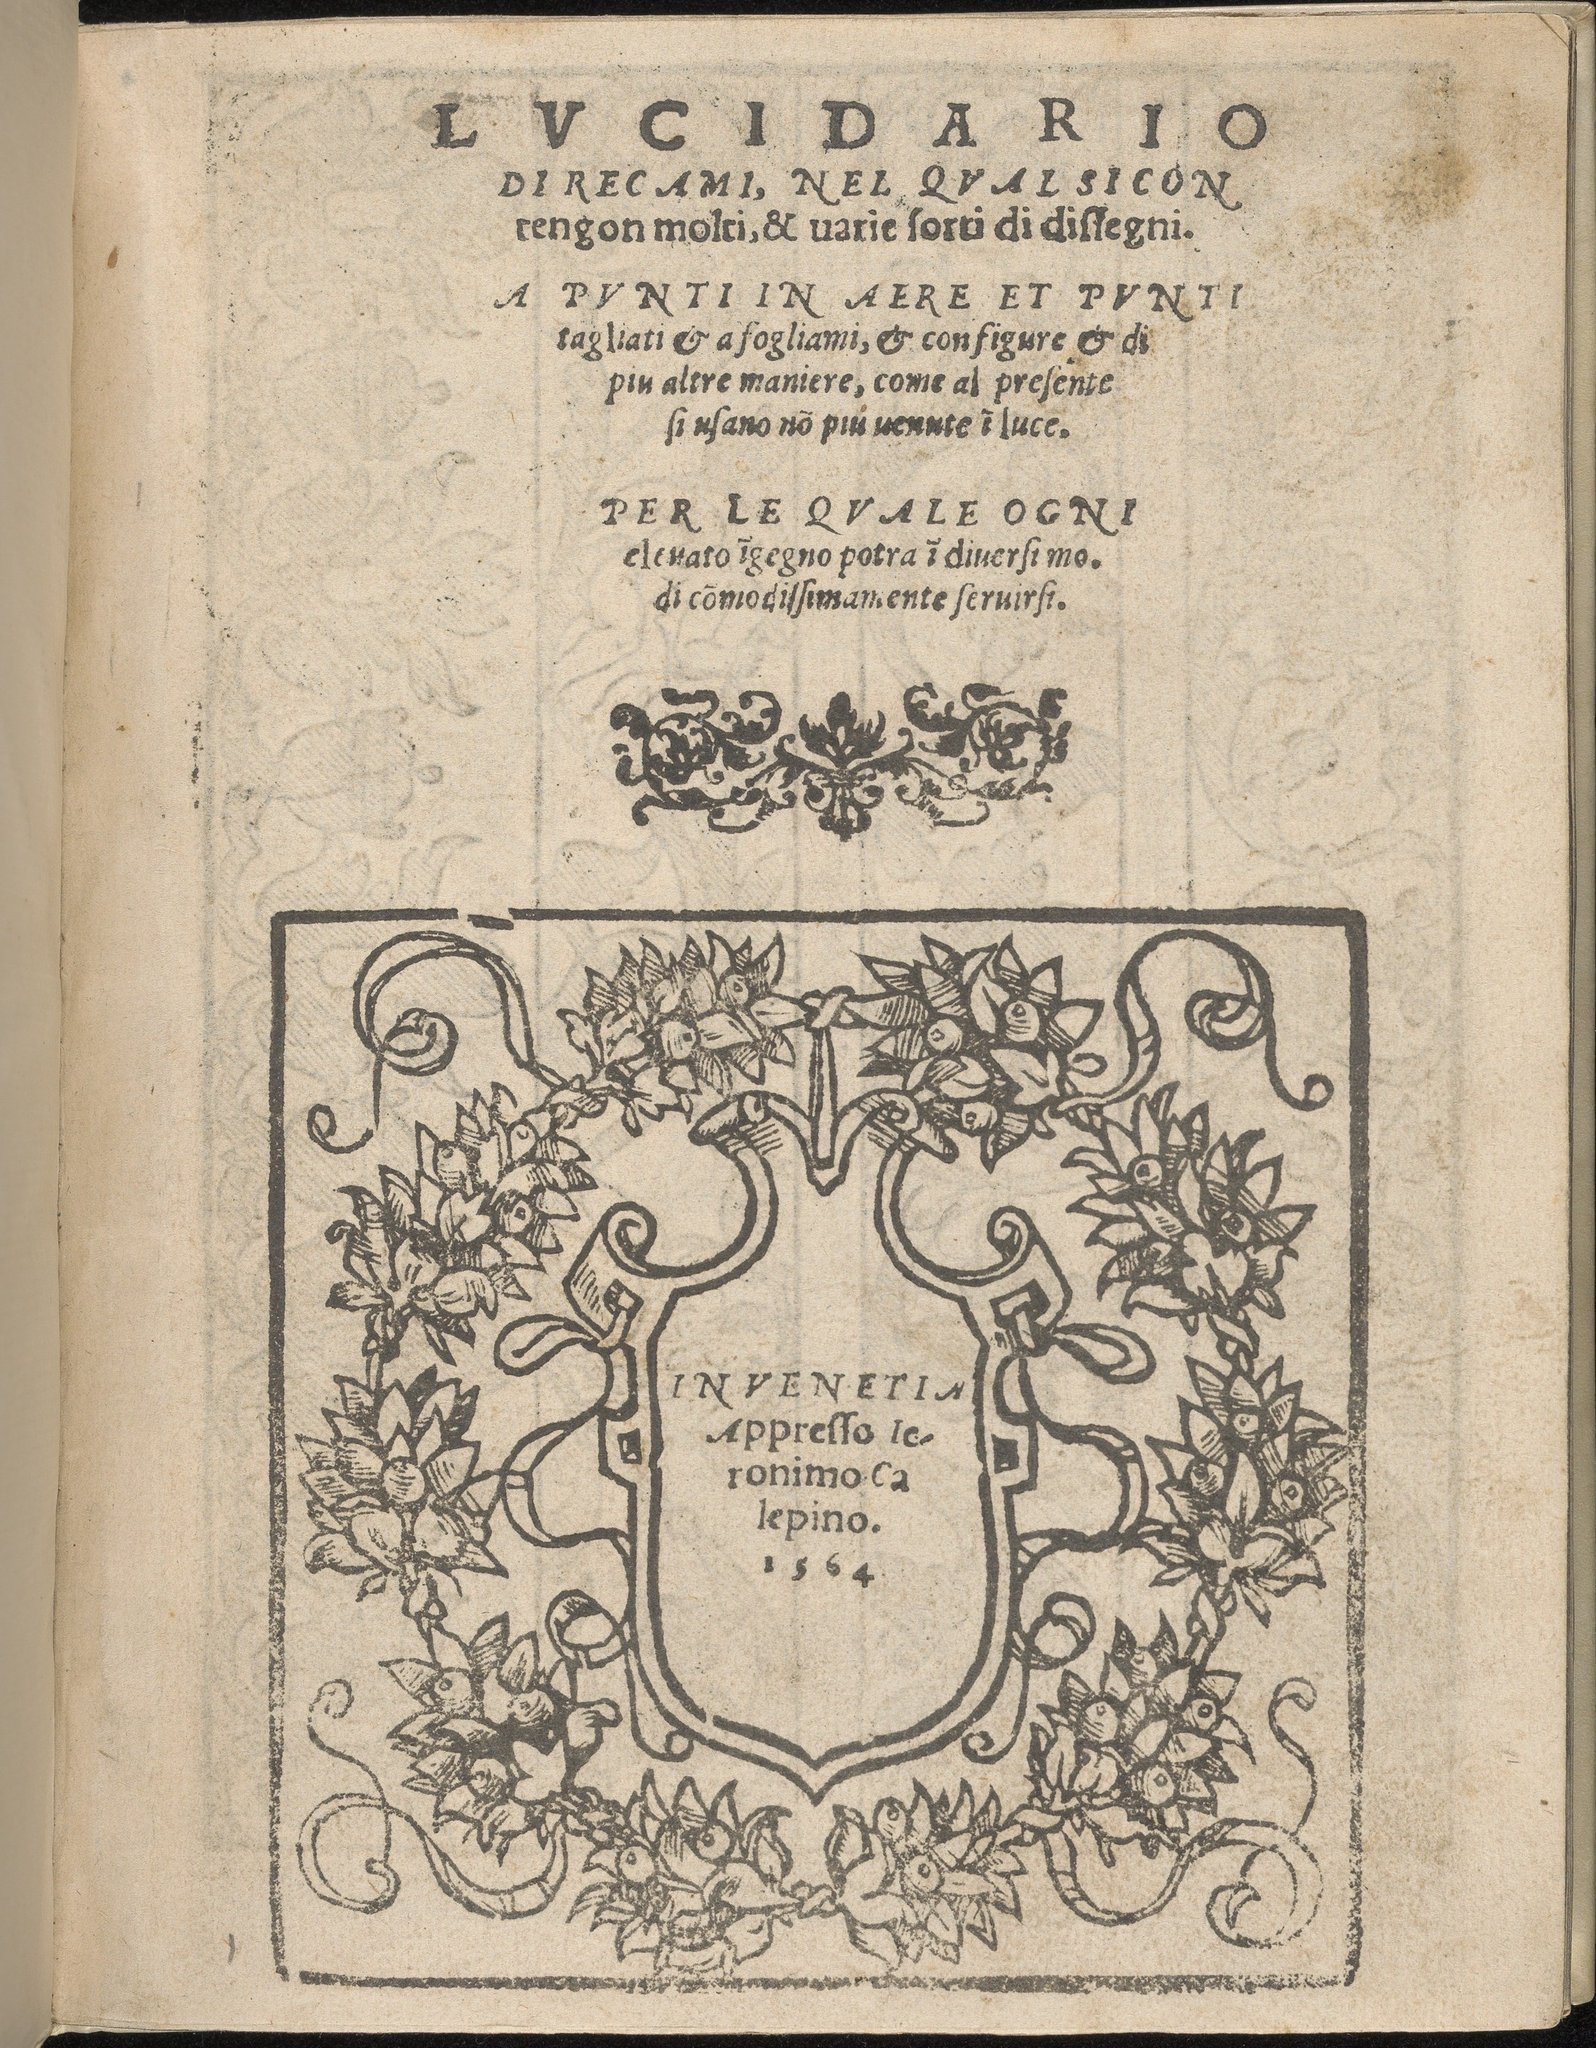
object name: book print ornament architecture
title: Lucidario di Recami, title page (recto)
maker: iseppo foresto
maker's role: designer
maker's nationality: italian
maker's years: 1520-1580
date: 1564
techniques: woodcut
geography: italy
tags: cartouches,flowers,wreaths